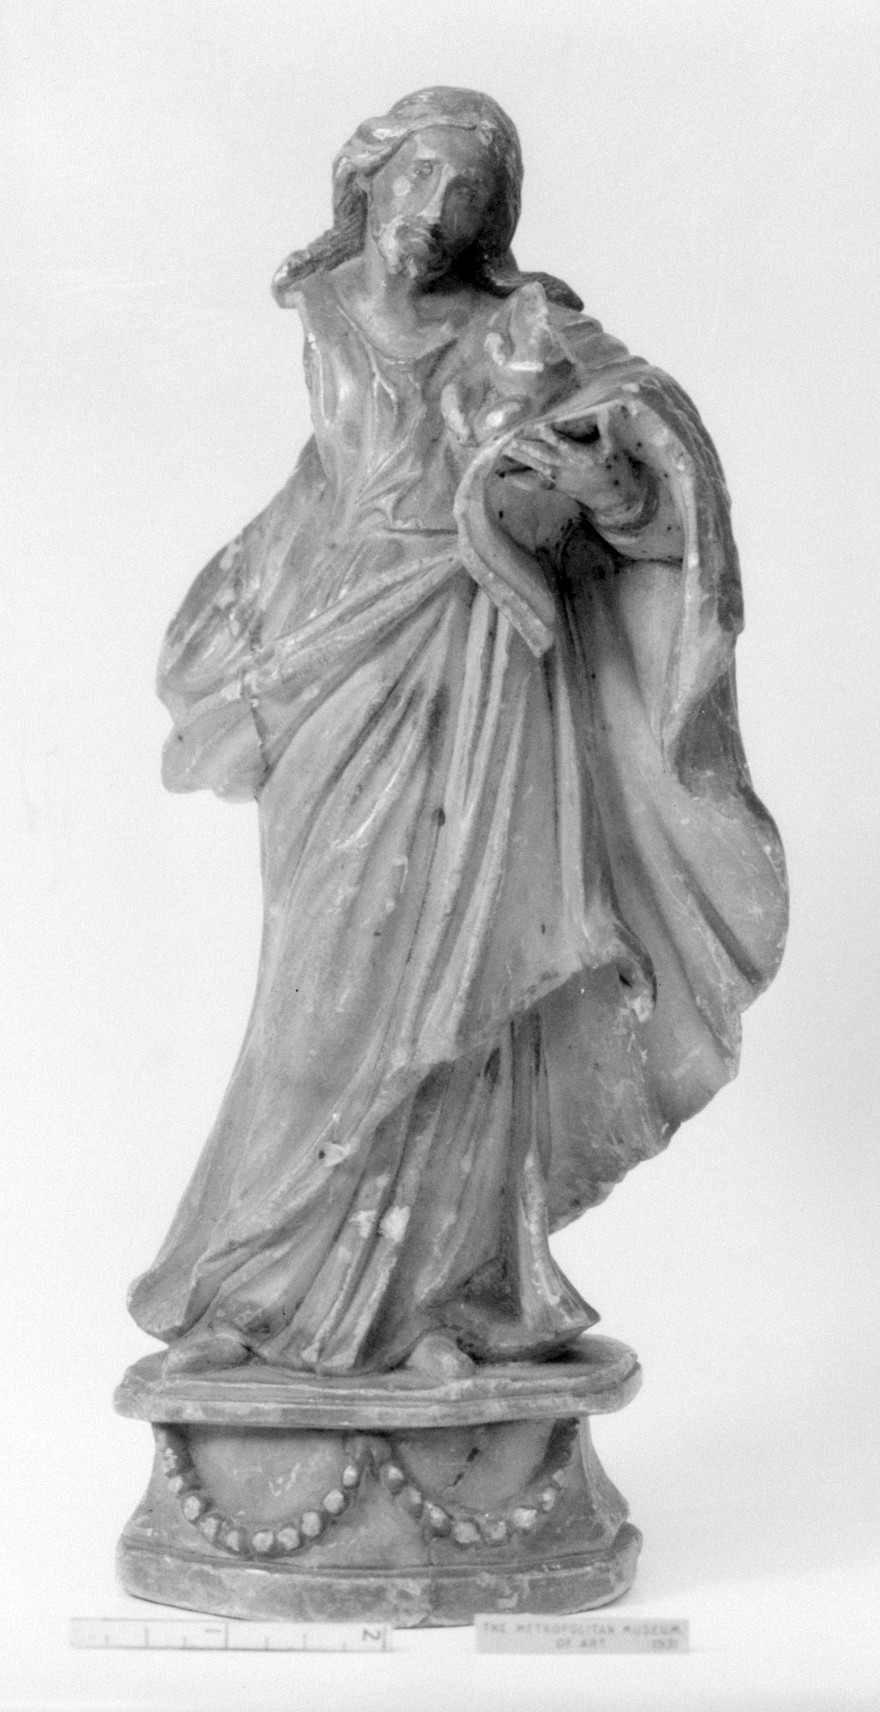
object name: statuette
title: Christ, the Good Shepherd, Carrying Child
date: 1601-1700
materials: alabaster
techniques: polychromy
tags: christ